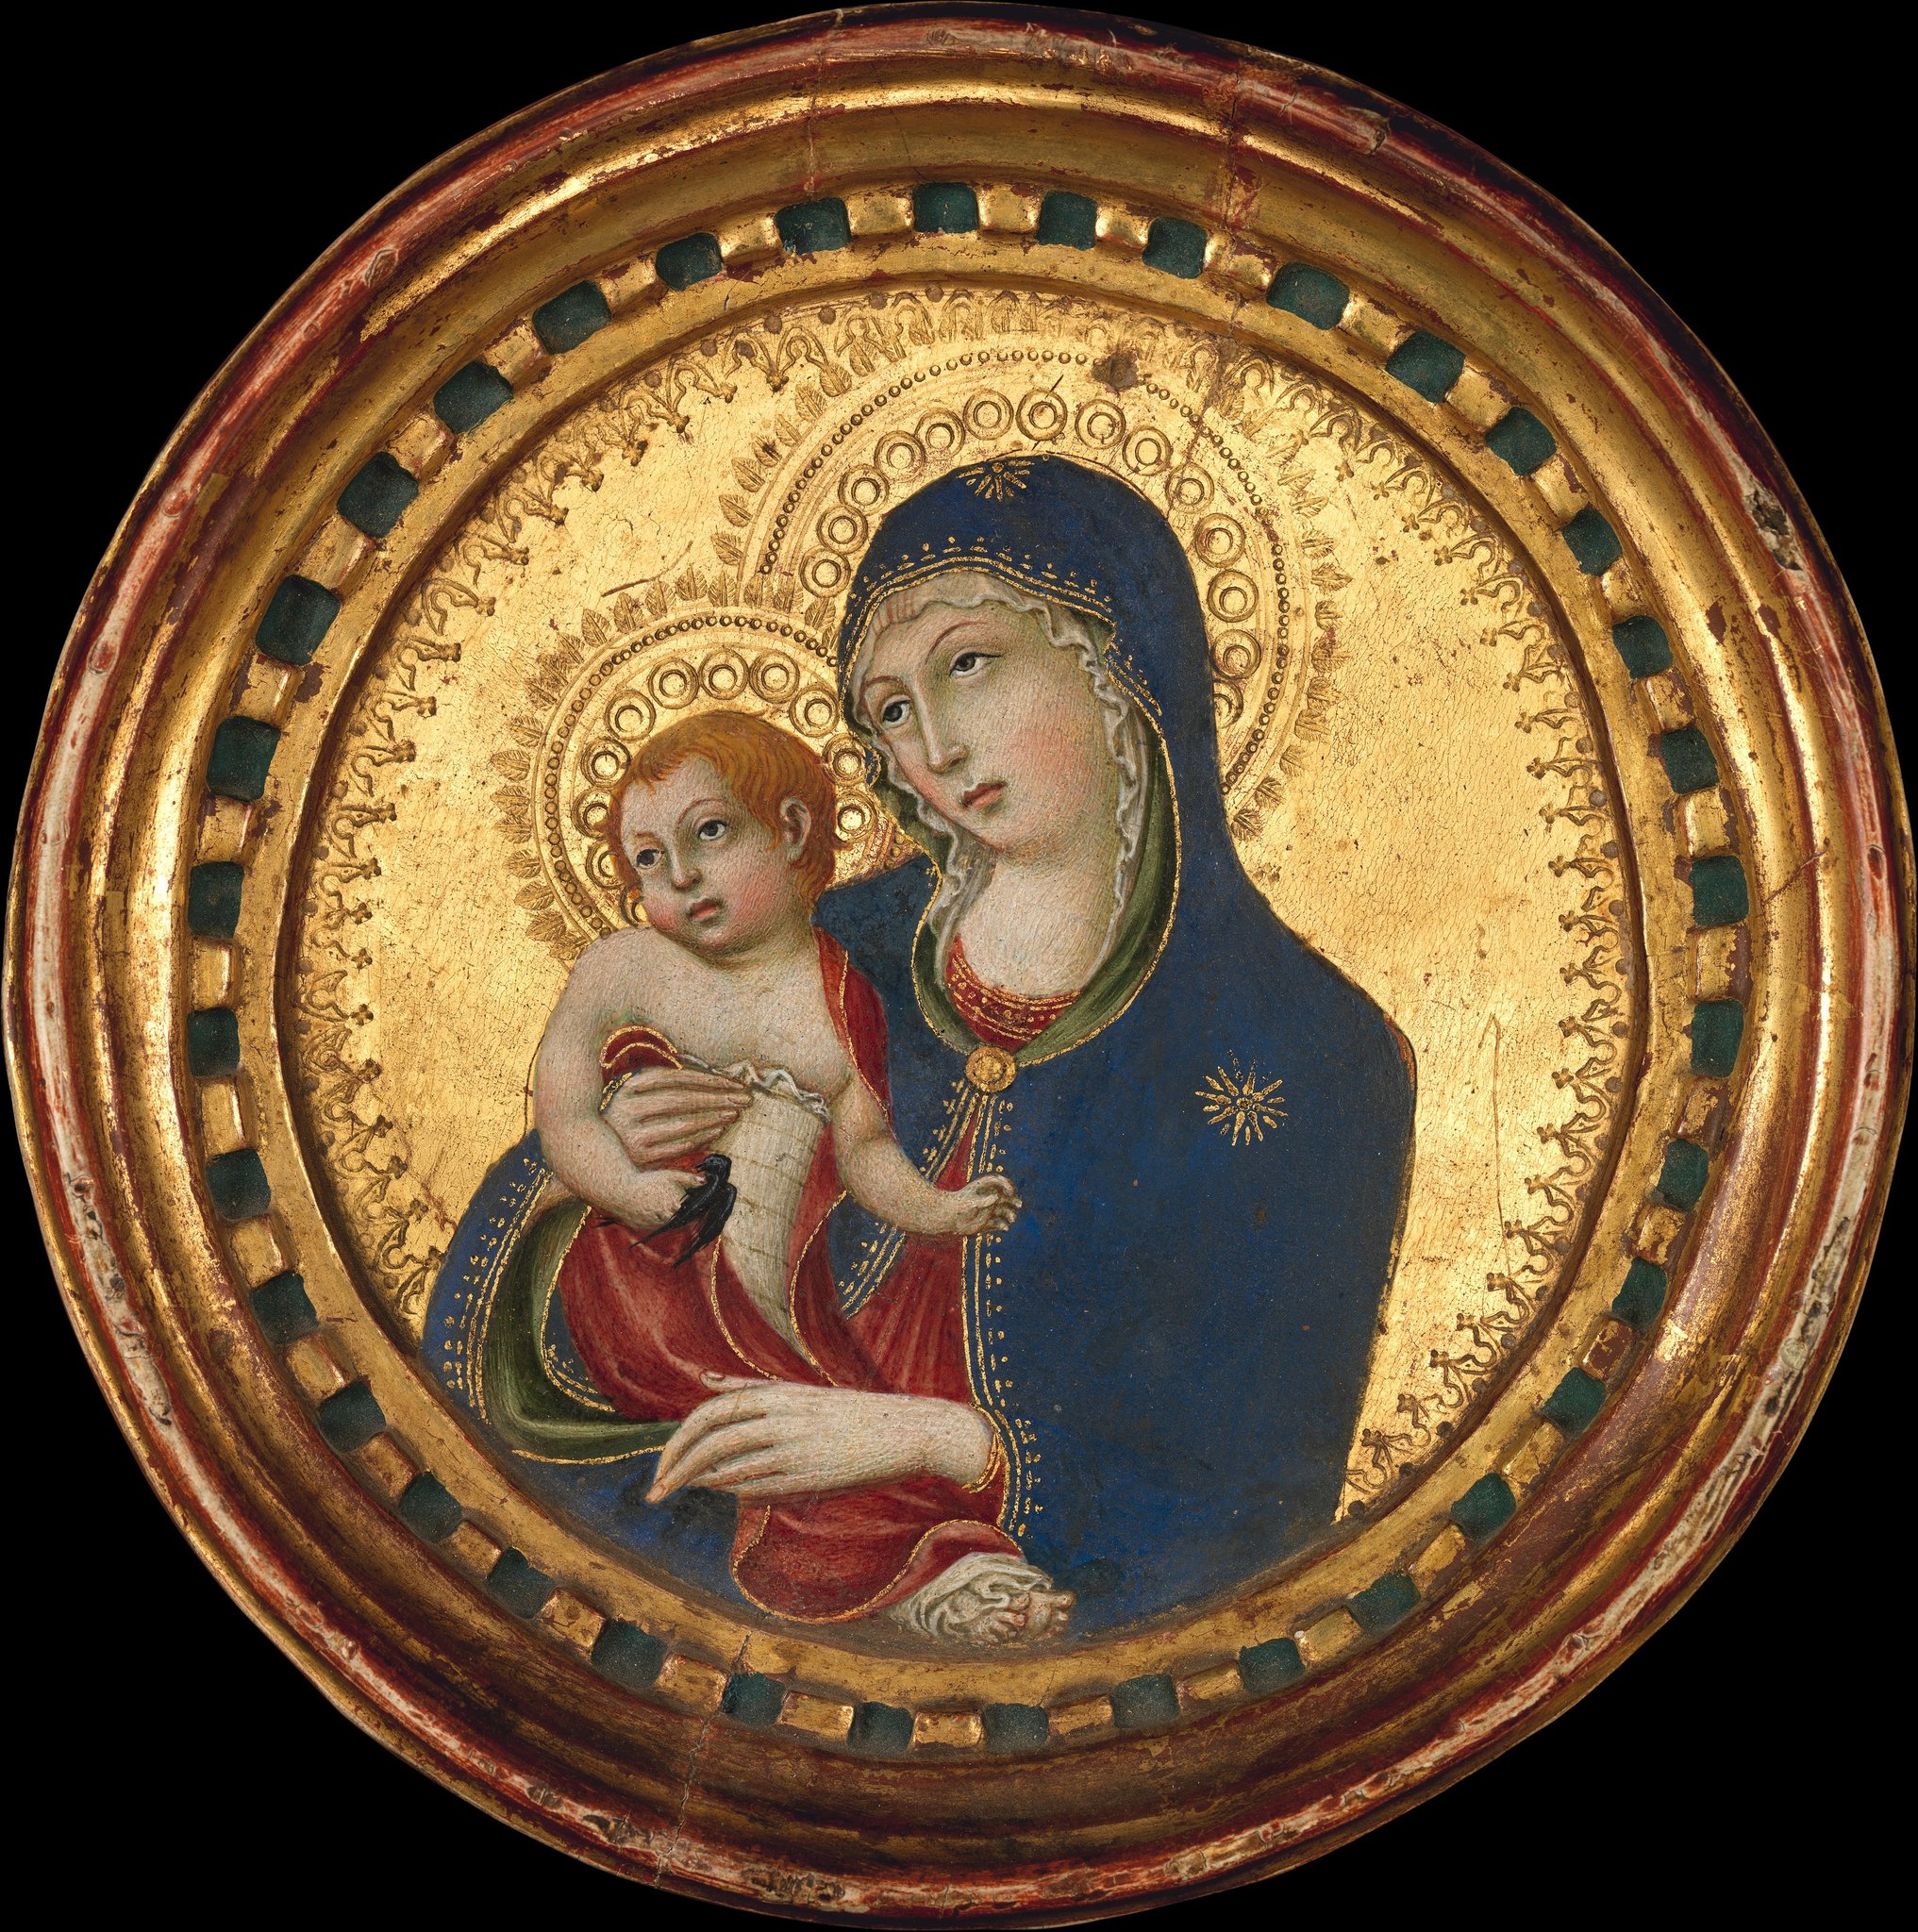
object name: painting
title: Madonna and Child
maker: sano di pietro (ansano di pietro di mencio)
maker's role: artist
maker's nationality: italian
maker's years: 1405-1481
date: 1434-1466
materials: gold leaf, paint, wood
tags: madonna and child